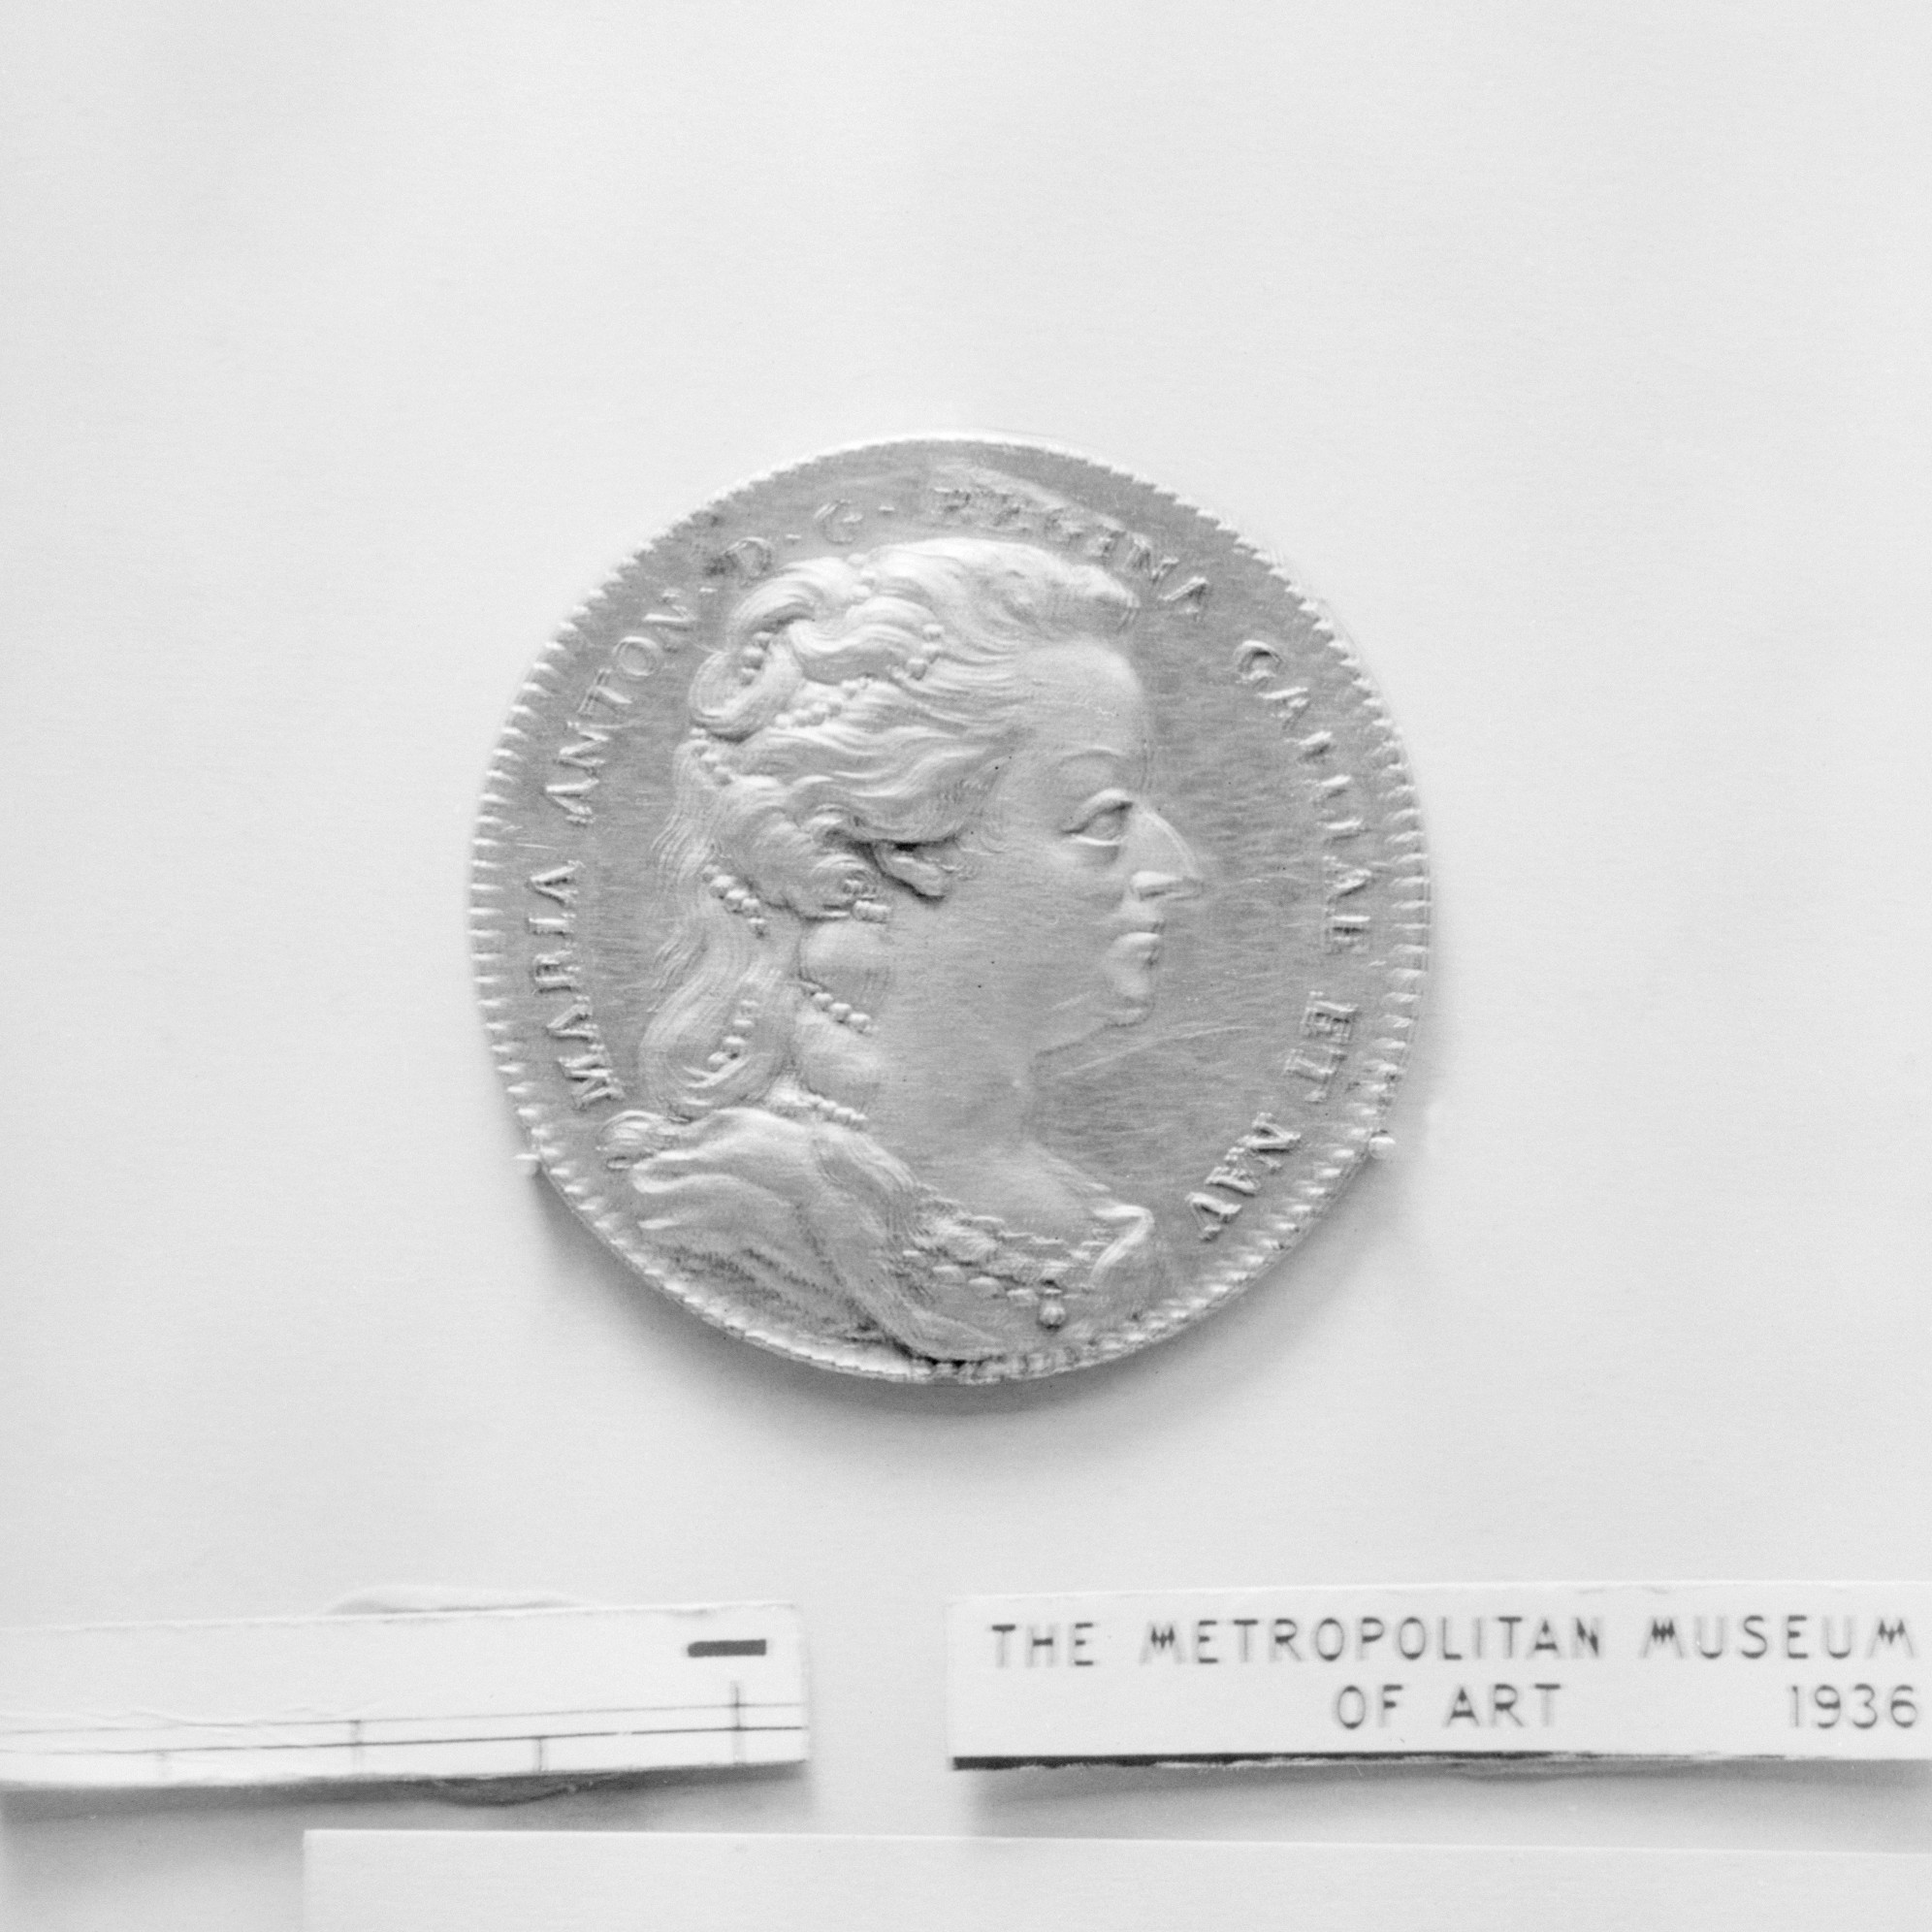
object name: medal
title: Marie Antoinette, Queen of France (1755–93)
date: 1767-1833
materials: gilt bronze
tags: marie antoinette,queens,profiles,women